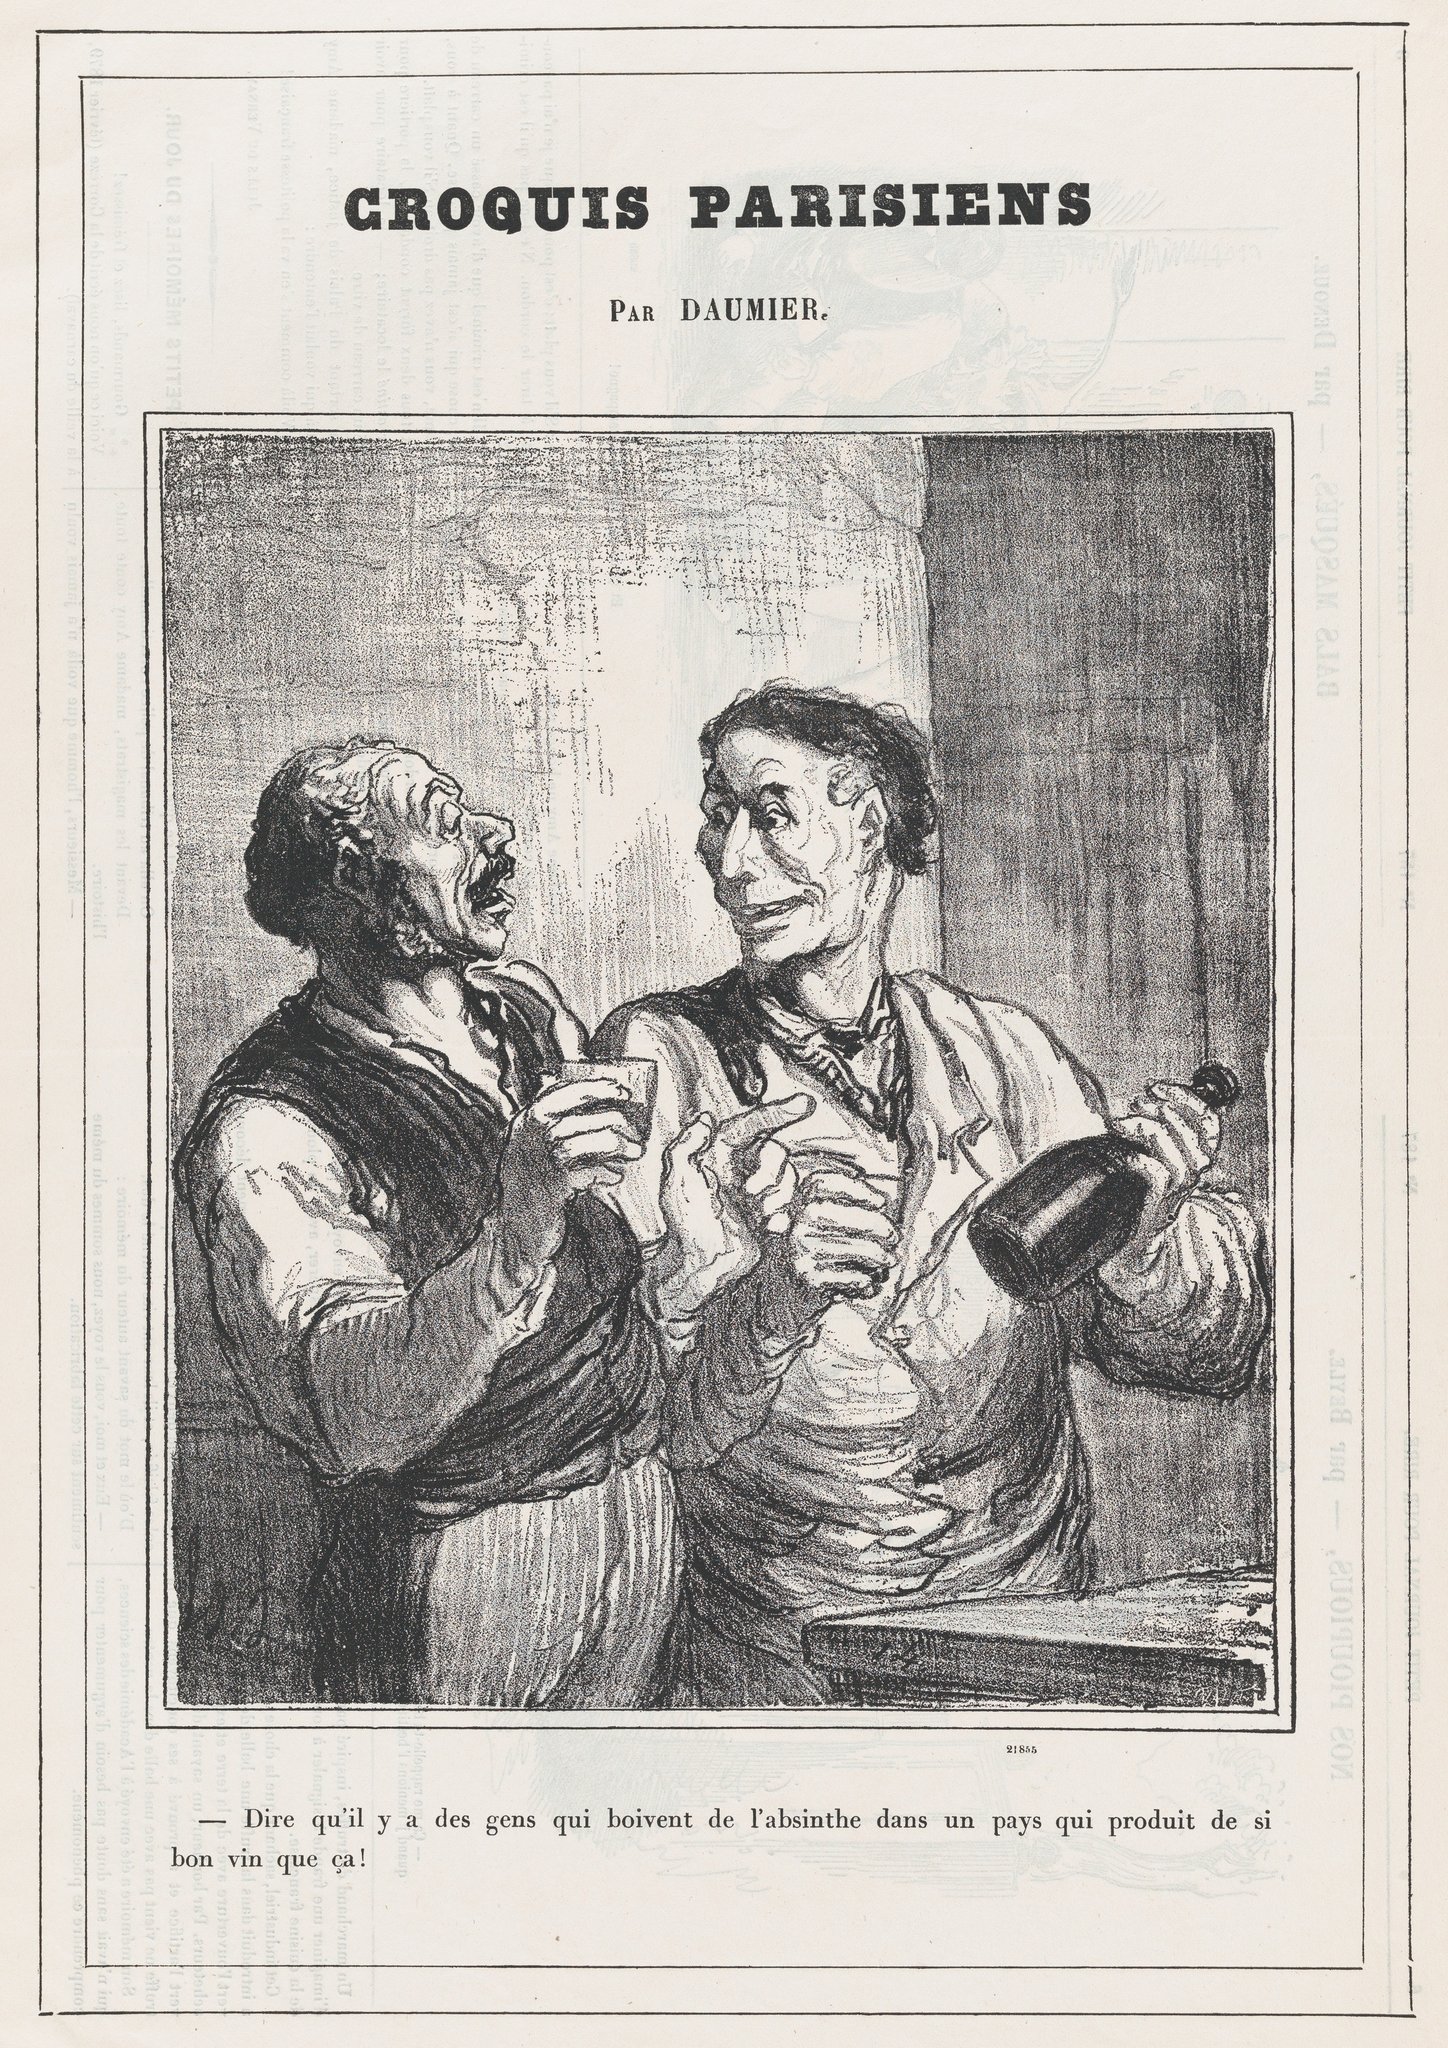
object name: print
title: Just imagine that there are people drinking absinthe..., from 'Parisian sketches,' published in Le Petit Journal pour Rire, January 30, 1864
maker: honoré daumier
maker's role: artist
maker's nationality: french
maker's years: 1808-1879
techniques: lithograph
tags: satire,men,drinking